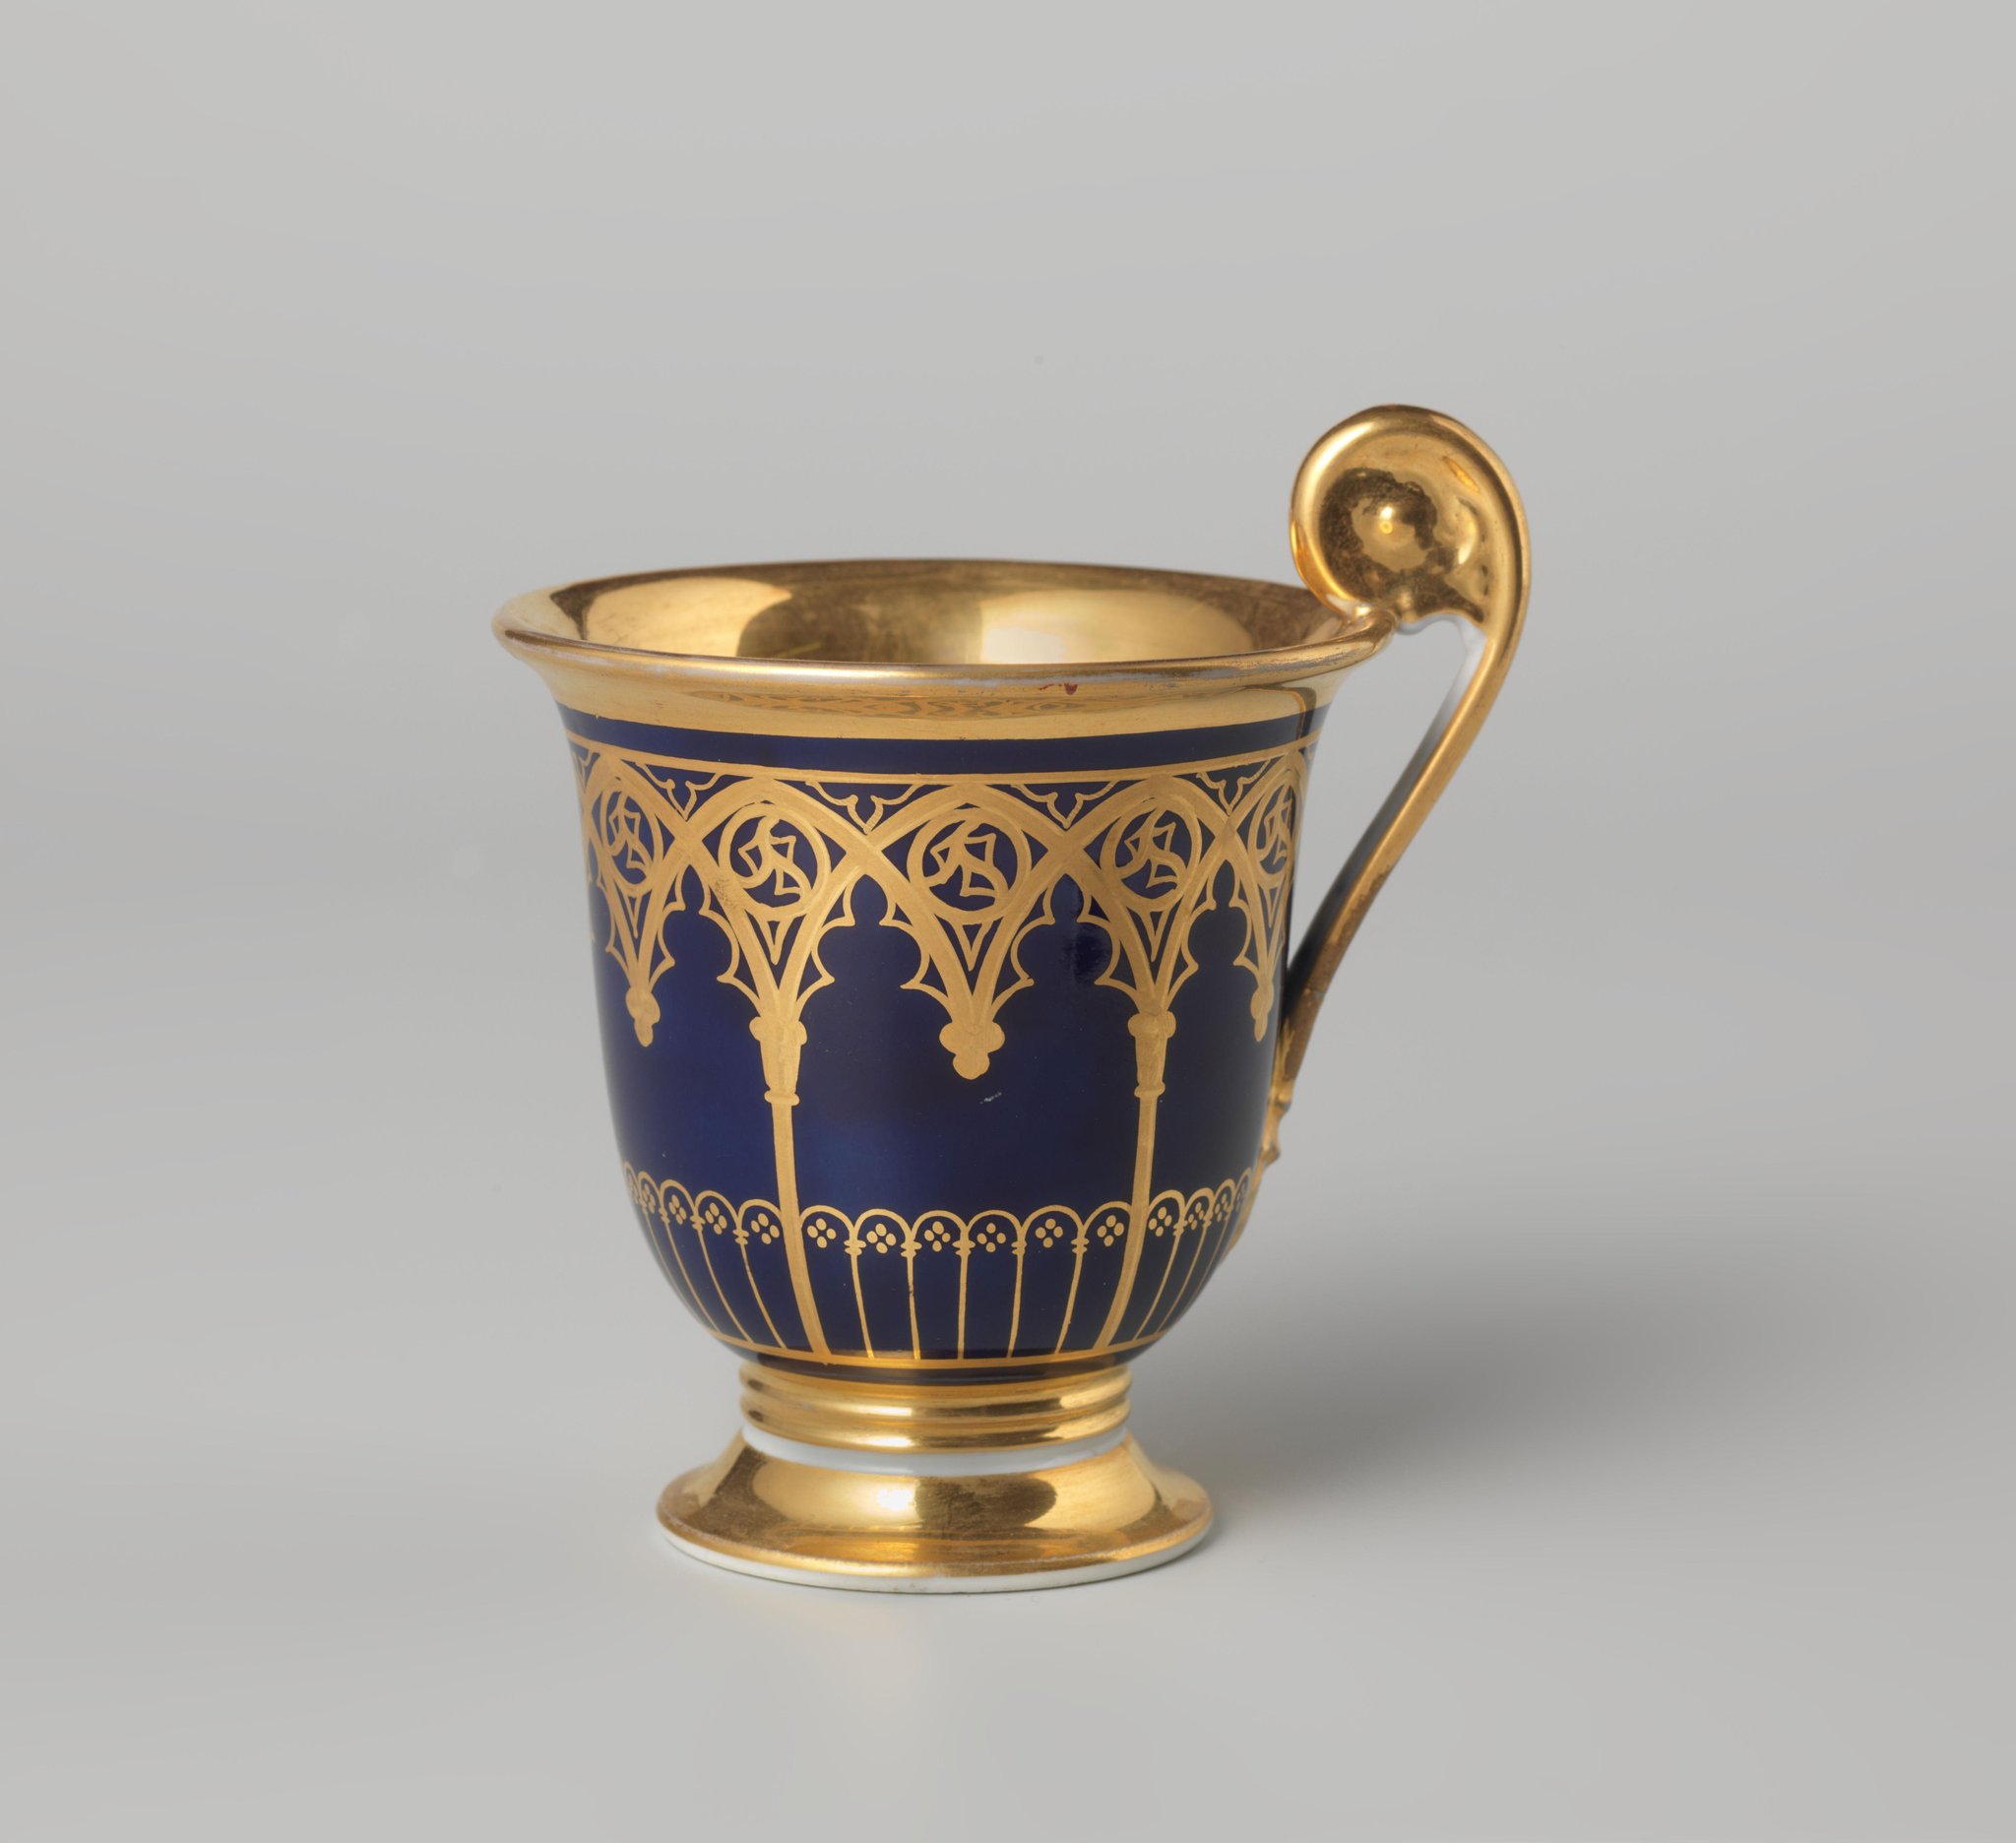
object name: cup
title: Cup with a gothic arcade decoration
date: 1800-1899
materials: cobalt, glaze, gold, paint, porcelain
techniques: firing, forming, gilding, turning, vitrification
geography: saint-yrieix-la-perche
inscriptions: mark: ‘vis’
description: Kop van porselein op spreidende voet en met een hoog, gekruld oor, beschilderd in onderglazuur blauw en op het glazuur goud. De buitenwand met een gotische boogdecoratie tegen een blauwe achtergrond. De voet, de rand, het oor en de helft van de binnenwand zijn bedekt met goud. In de krul van het oor een gemodelleerde rozet. Gemerkt op de onderzijde met de groene vis.